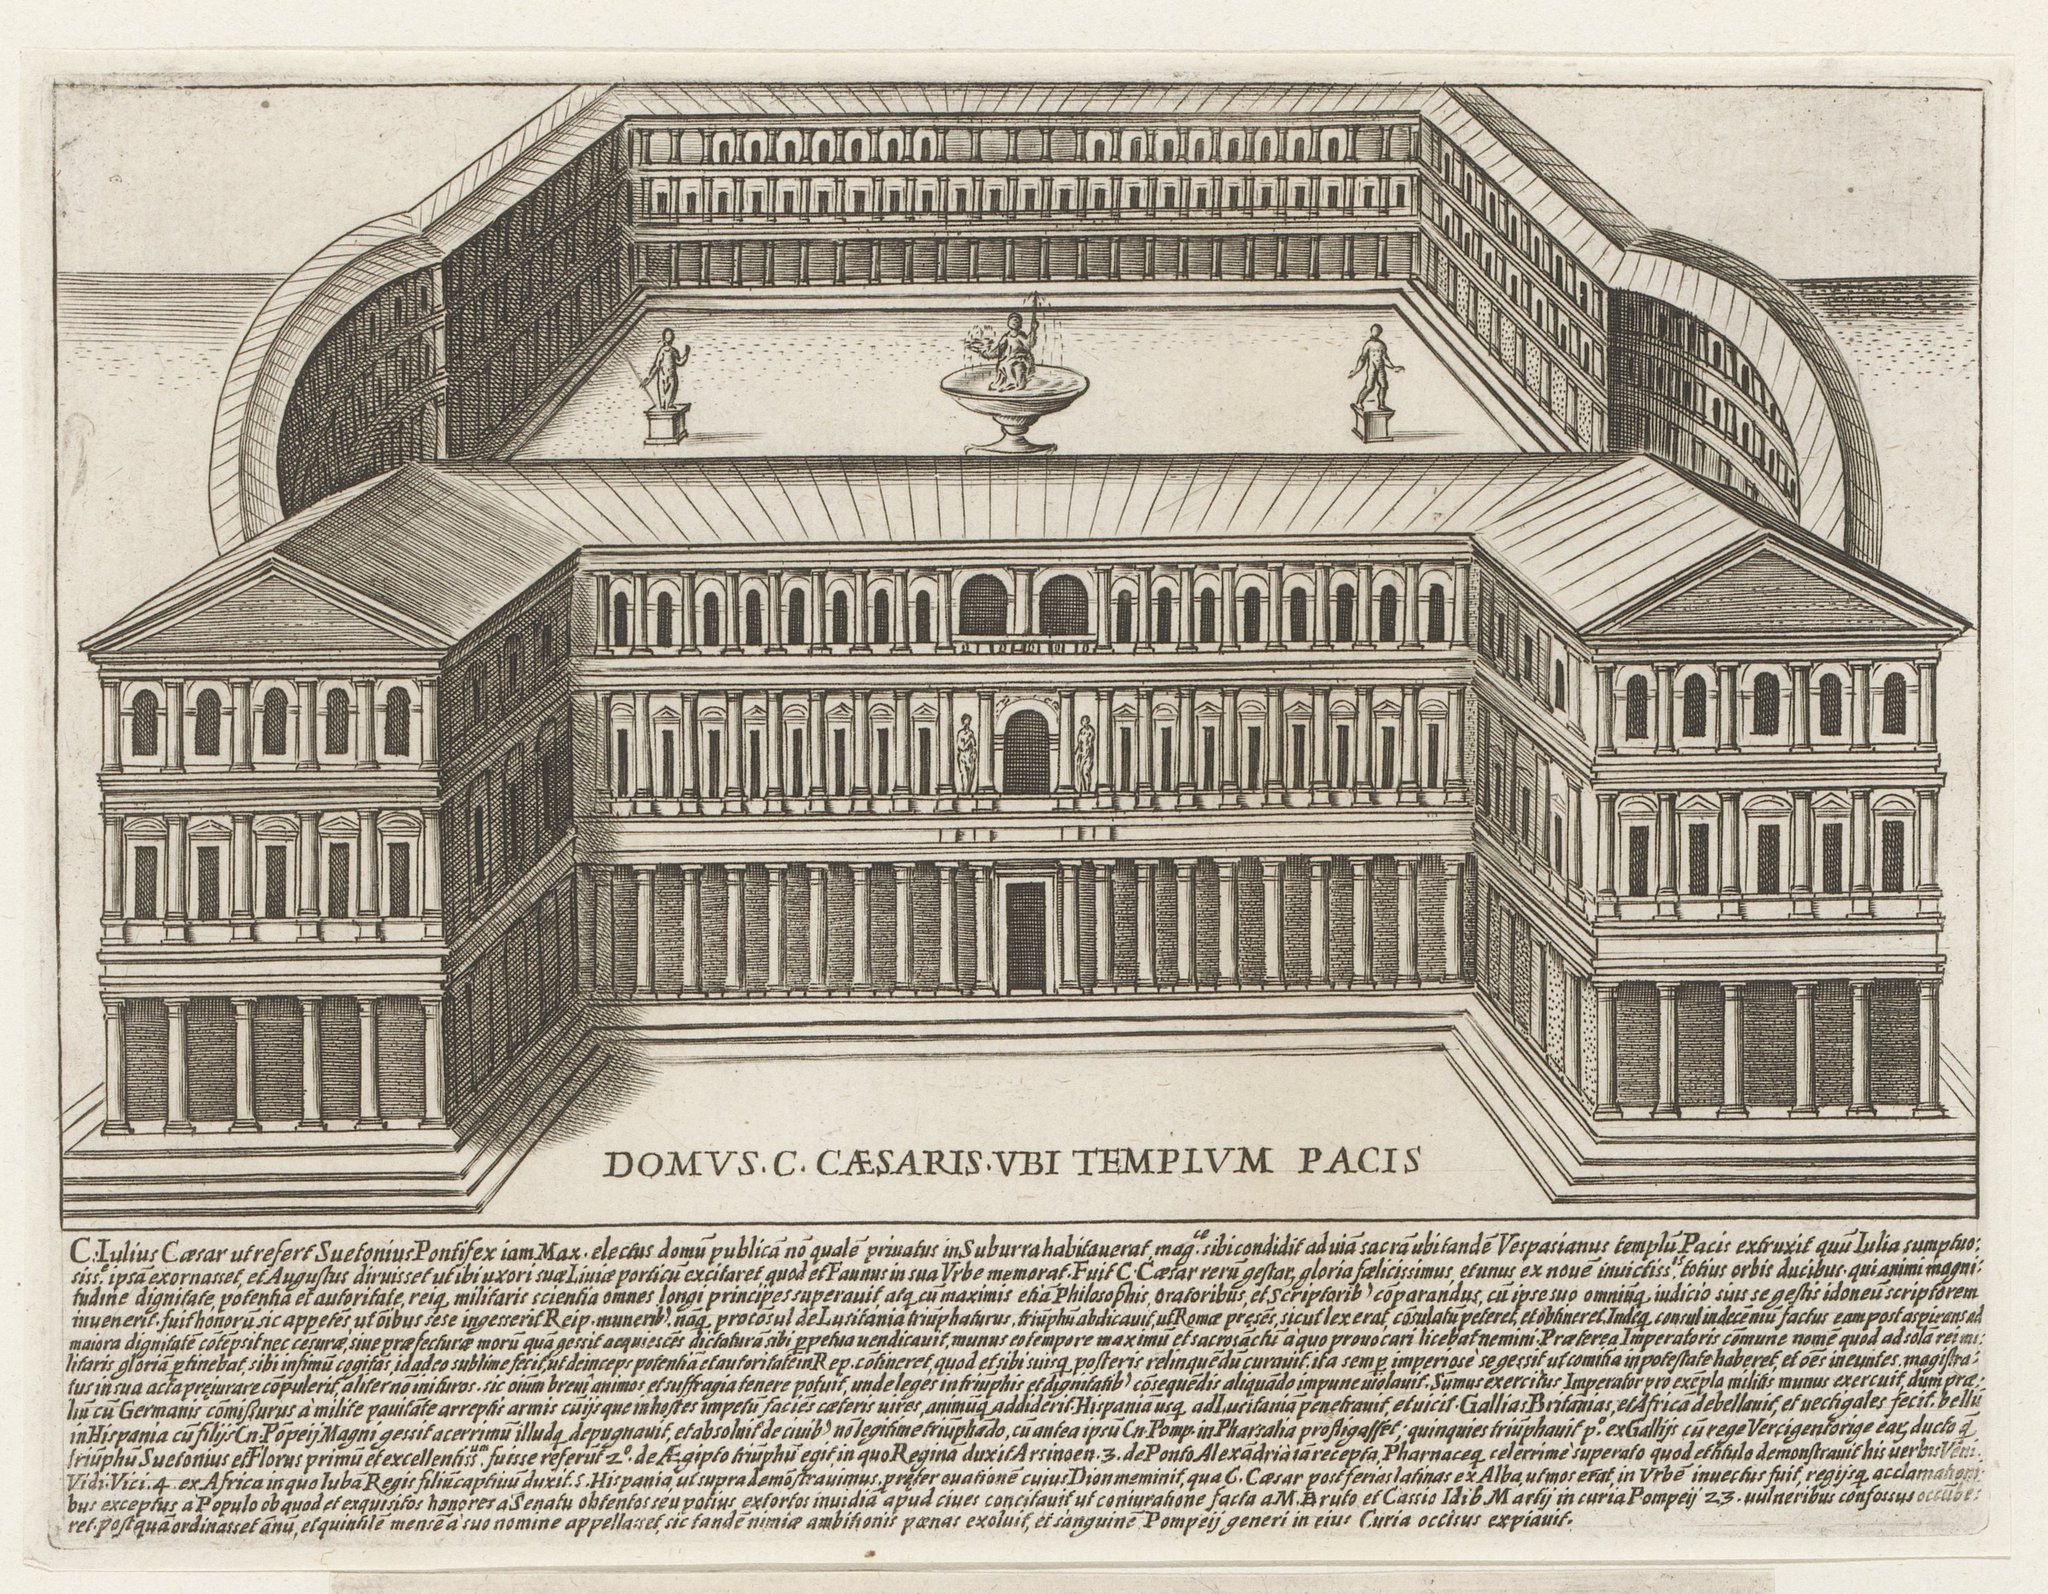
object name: print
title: Antiquae Urbis Splendor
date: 1612-1628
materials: paper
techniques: etching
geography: rome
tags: representation of real building (either existing or having existed), hôtel, i.e. small palace in city, rome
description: Deze prent maakt deel uit van een set van 158 prenten (+ titelprenten), die verscheen in vier delen. In 1612 verschenen delen één en twee. In 1615 verscheen het derde deel en in 1628 verscheen deel vier. In 1637 publiceerde Vitale Mascardi de eerste heruitgave van de gehele set met nummering.